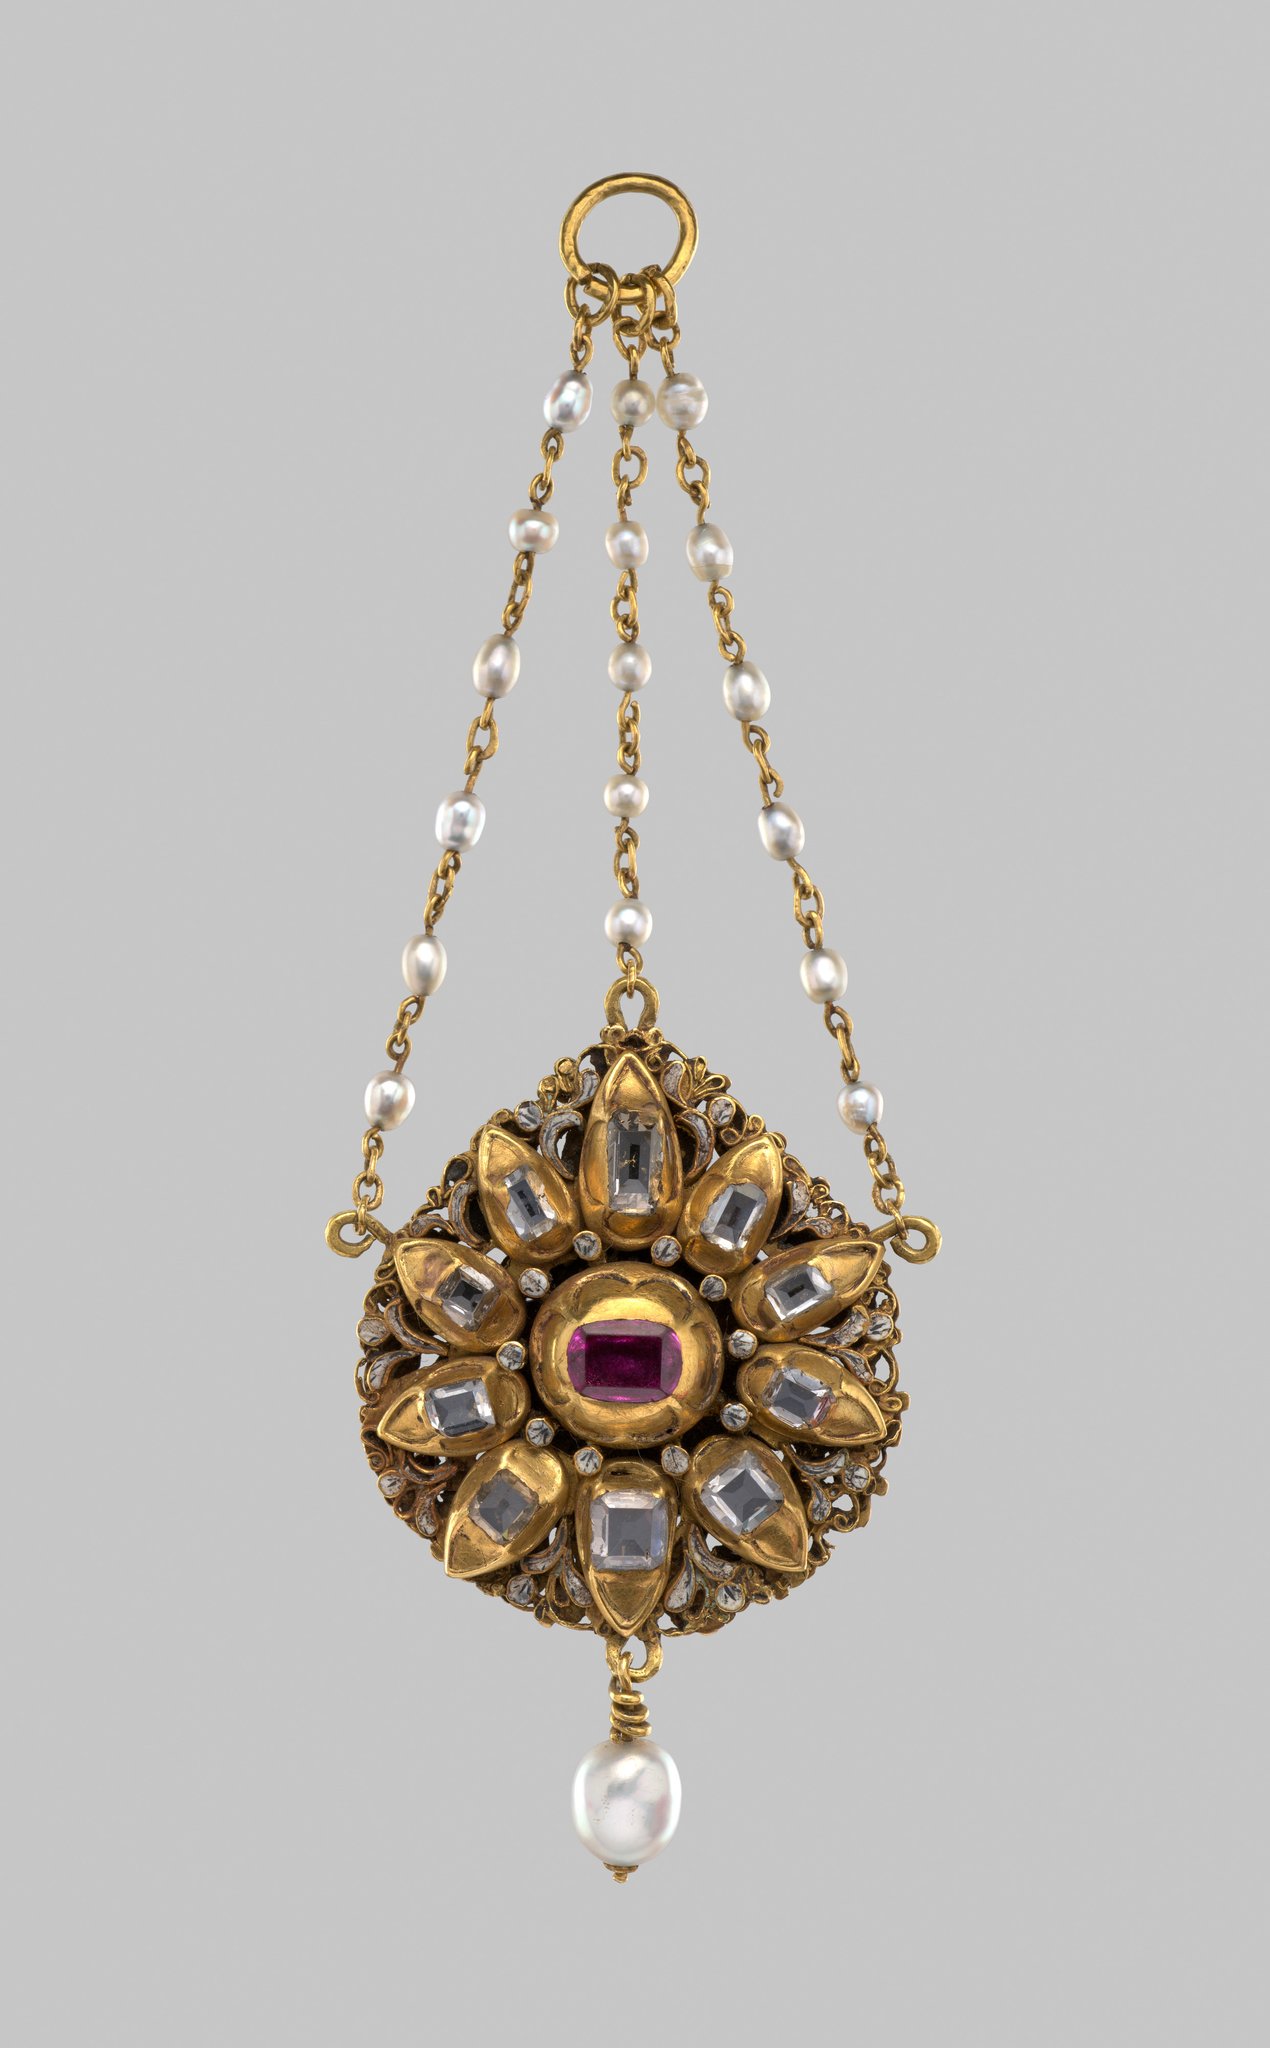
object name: pendant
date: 1620-1630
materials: diamond, enamel, gold, pearl, gemstone